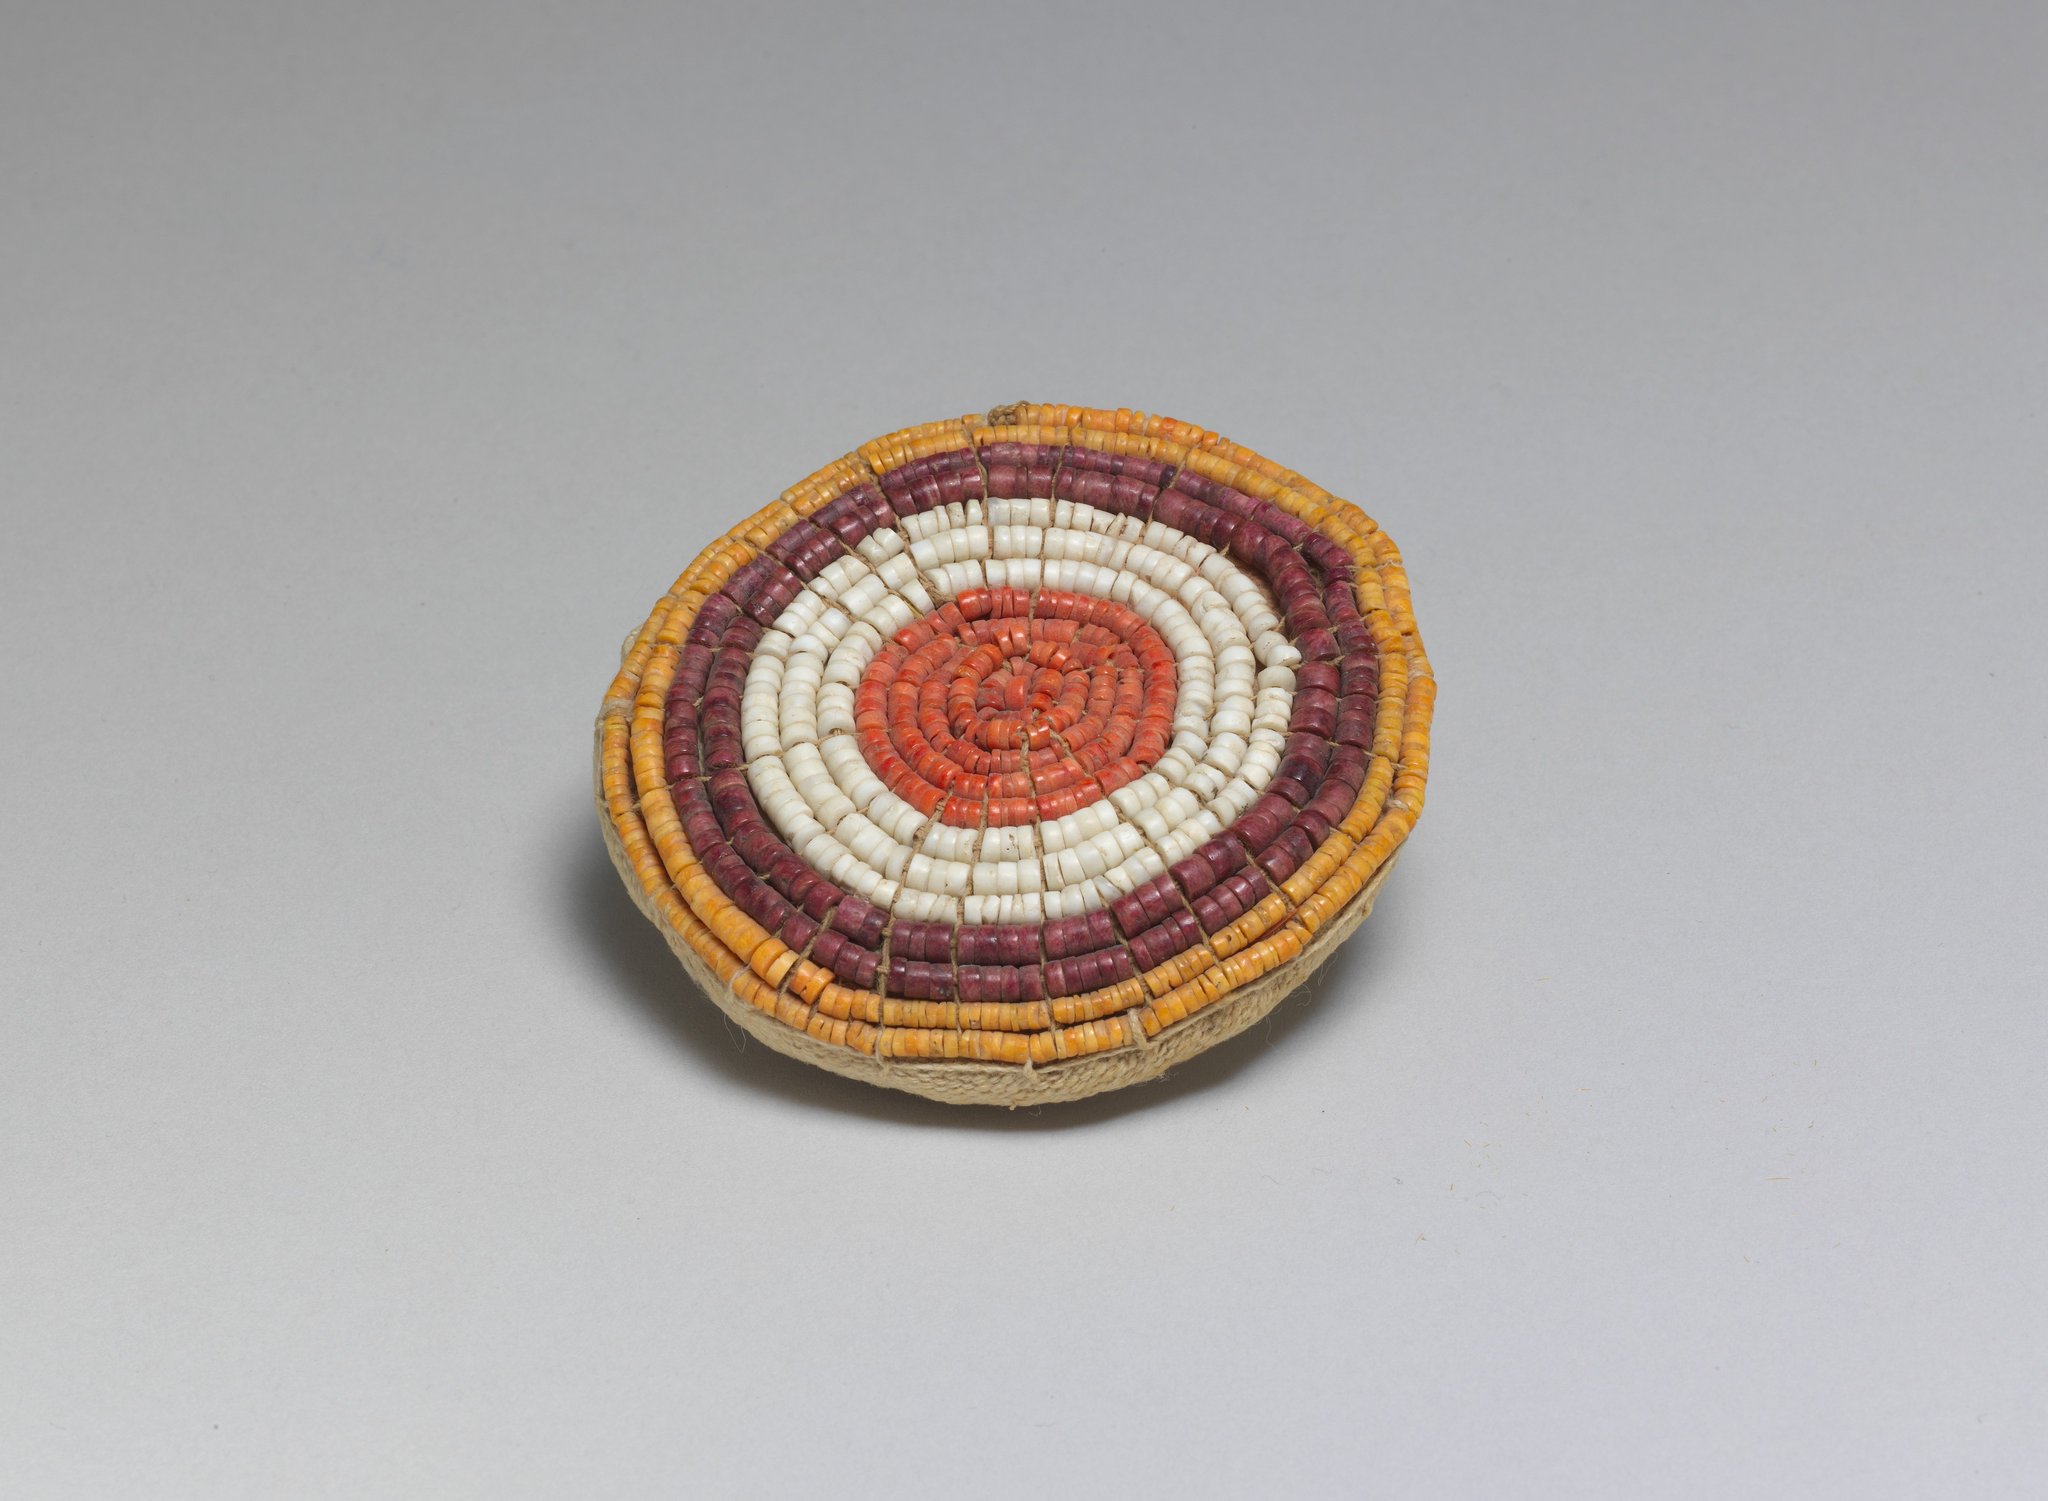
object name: pillow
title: Beaded Pillow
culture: chancay or chimú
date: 1301-1500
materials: cotton, shell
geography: peru